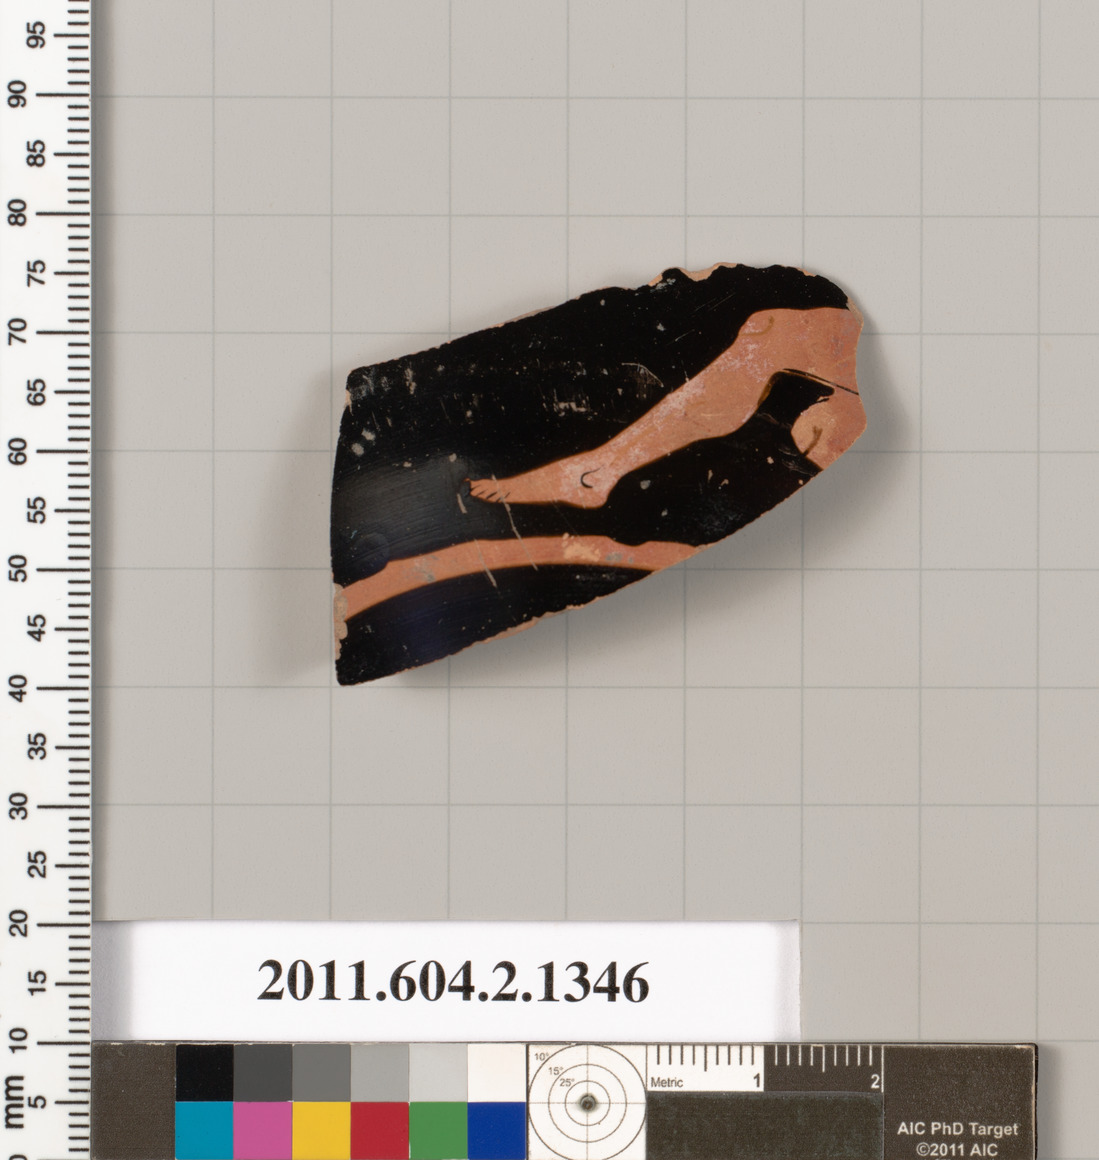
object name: skyphos fragment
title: Terracotta fragment of a skyphos (deep drinking cup)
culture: greek, attic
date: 450-430 BCE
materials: terracotta